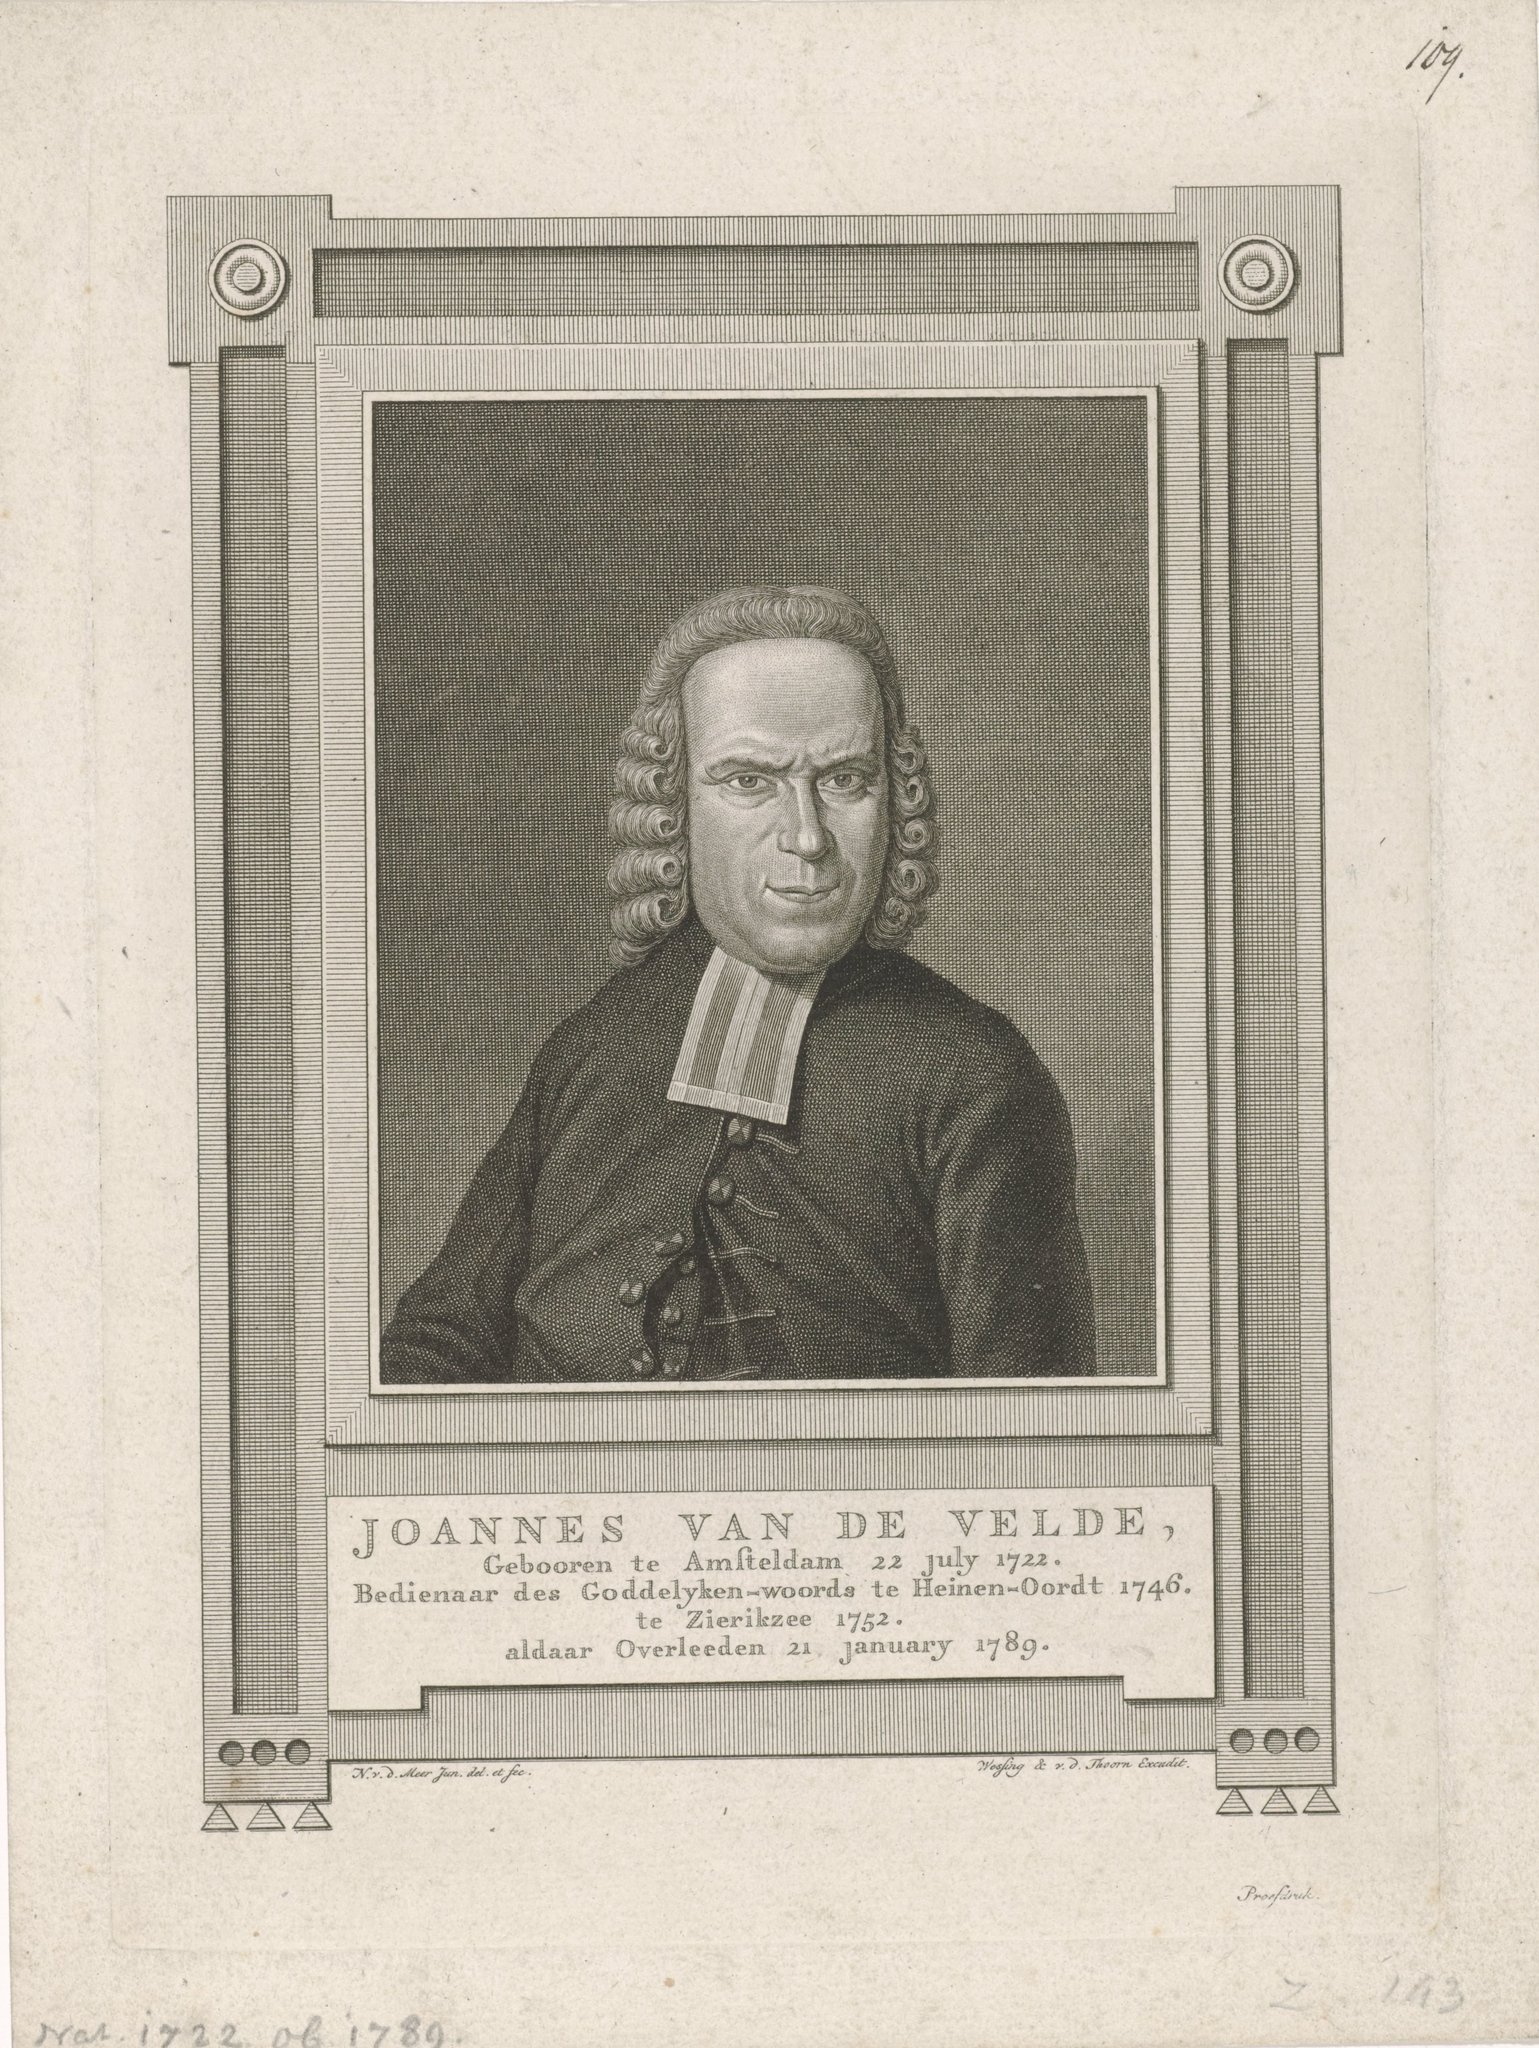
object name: print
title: Portret van Joannes van de Velde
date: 1789-1791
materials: paper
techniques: etching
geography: amsterdam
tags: zierikzee, predikant, joannes van de velde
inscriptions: collector's mark: Lugt 2228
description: Portret van Joannes van de Velde, predikant te Heinenoord en Zierikzee.